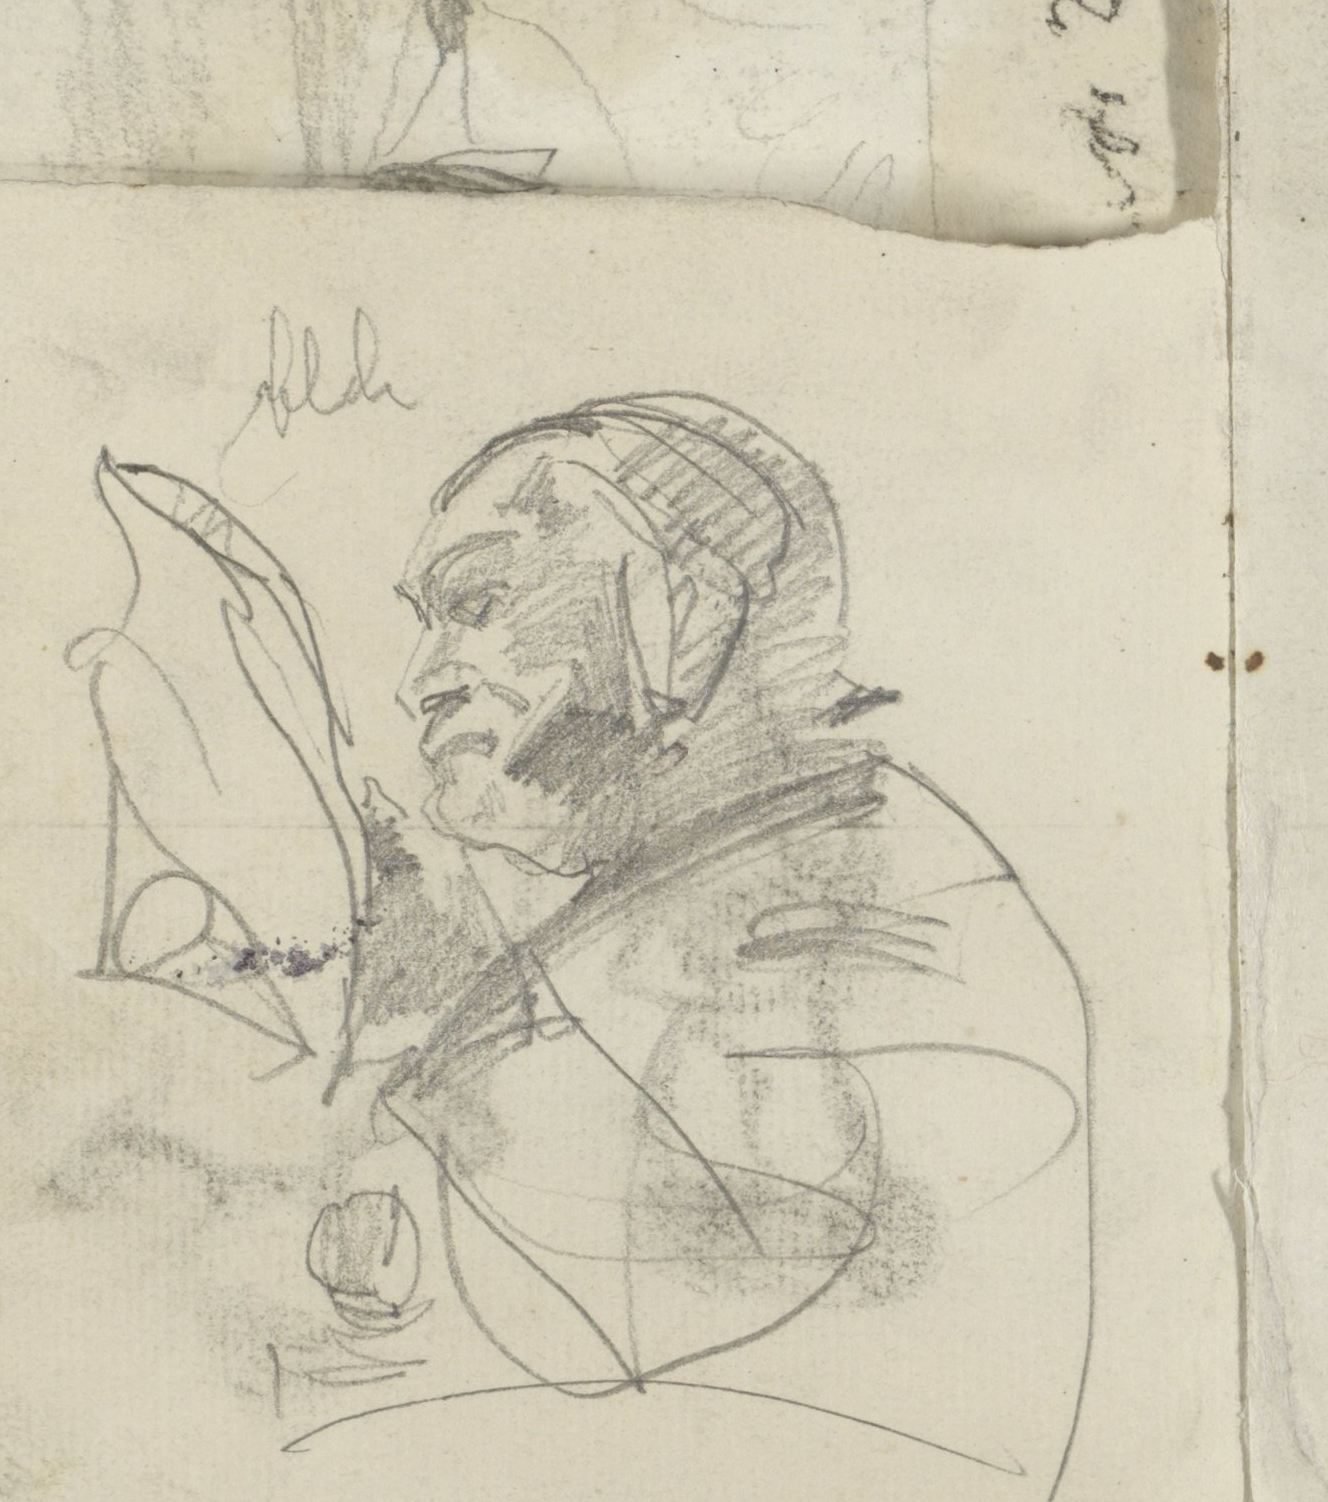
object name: sketchbook leaf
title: Mannenbuste en een kostuumstudie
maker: george hendrik breitner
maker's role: draughtsman, painter, print maker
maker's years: 1857-1923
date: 1881-1883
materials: paper, pencil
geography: rotterdam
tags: adult man, clothes, costume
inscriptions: annotation: ‘[...]’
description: Pagina 3 uit een schetsboek met 27 bladen.